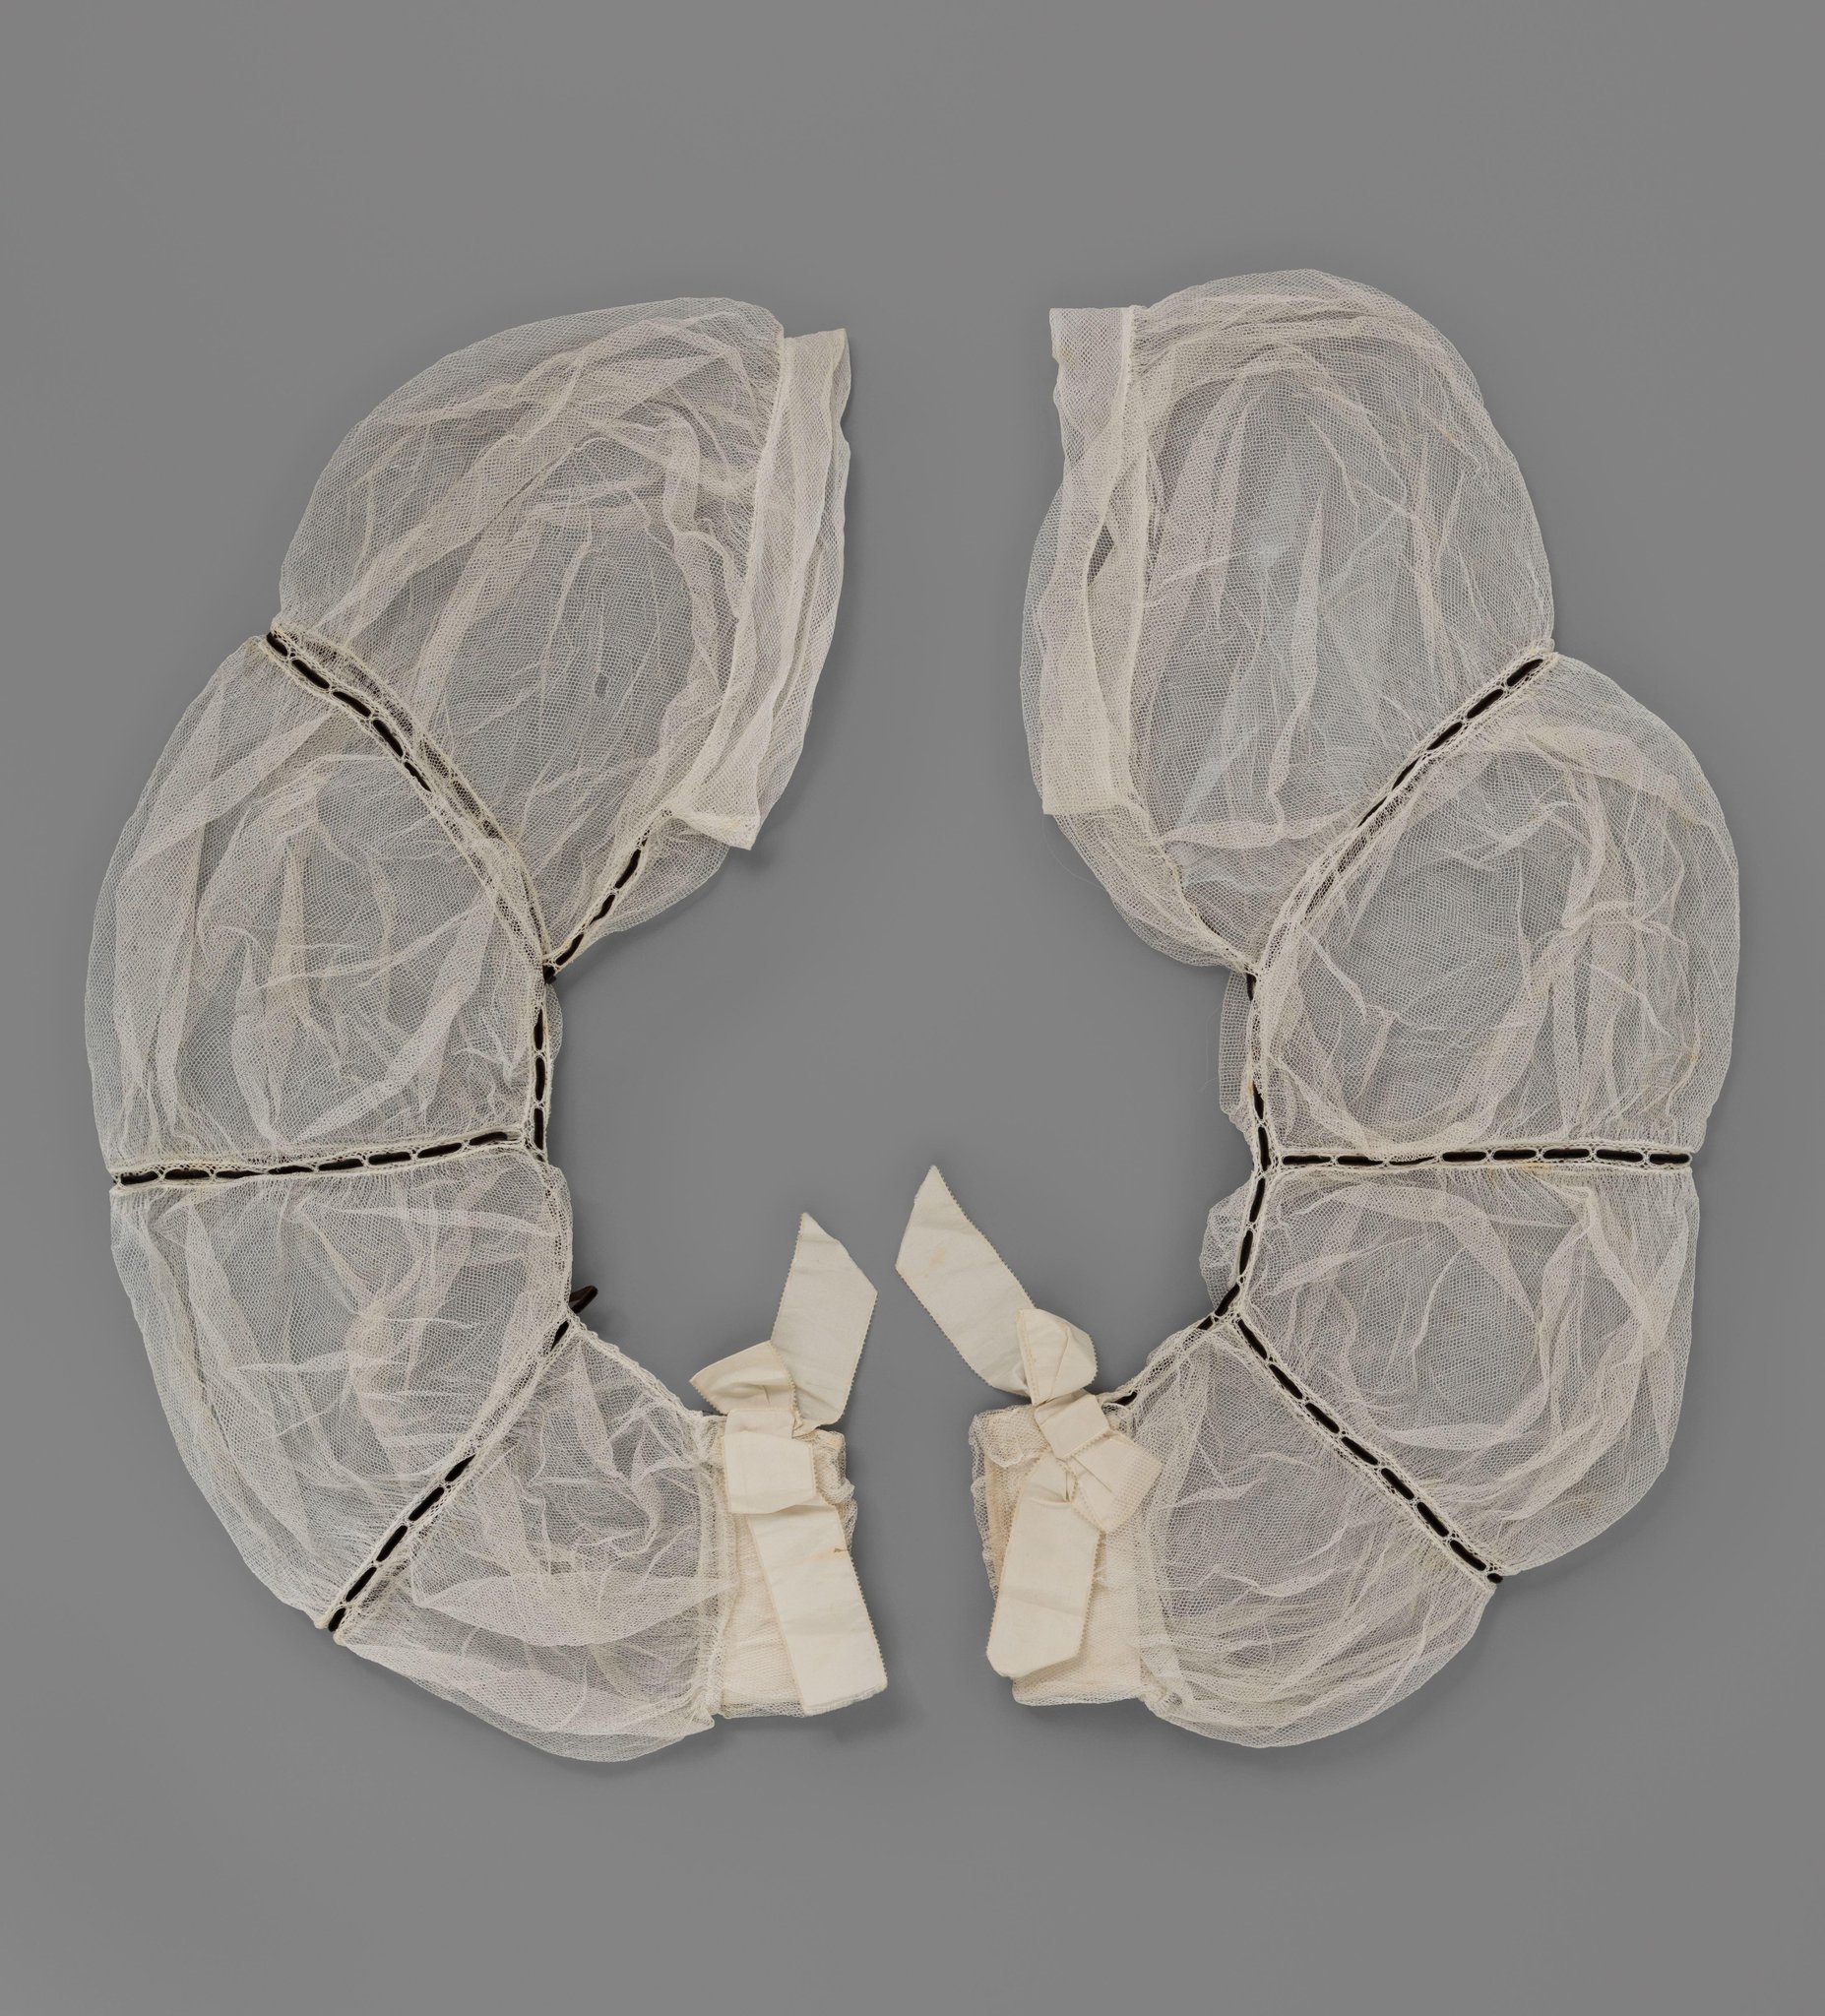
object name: womenswear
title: Ondermouw van tule met drie insnoeringen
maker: Anonymous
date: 1850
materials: ribbon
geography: netherlands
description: Paar "Michelin"- mouwen van tulle en zwart bandfluweel. De rond geknipte mouwen zijn driemaal ingesnoerd met een kanten tussenzetsel waardoor de fluweeltjes zijn geregen. zo is ook de binnen naad versierd. Nauw manchtje. Gevuld en versierd met wit lint en een strookje.